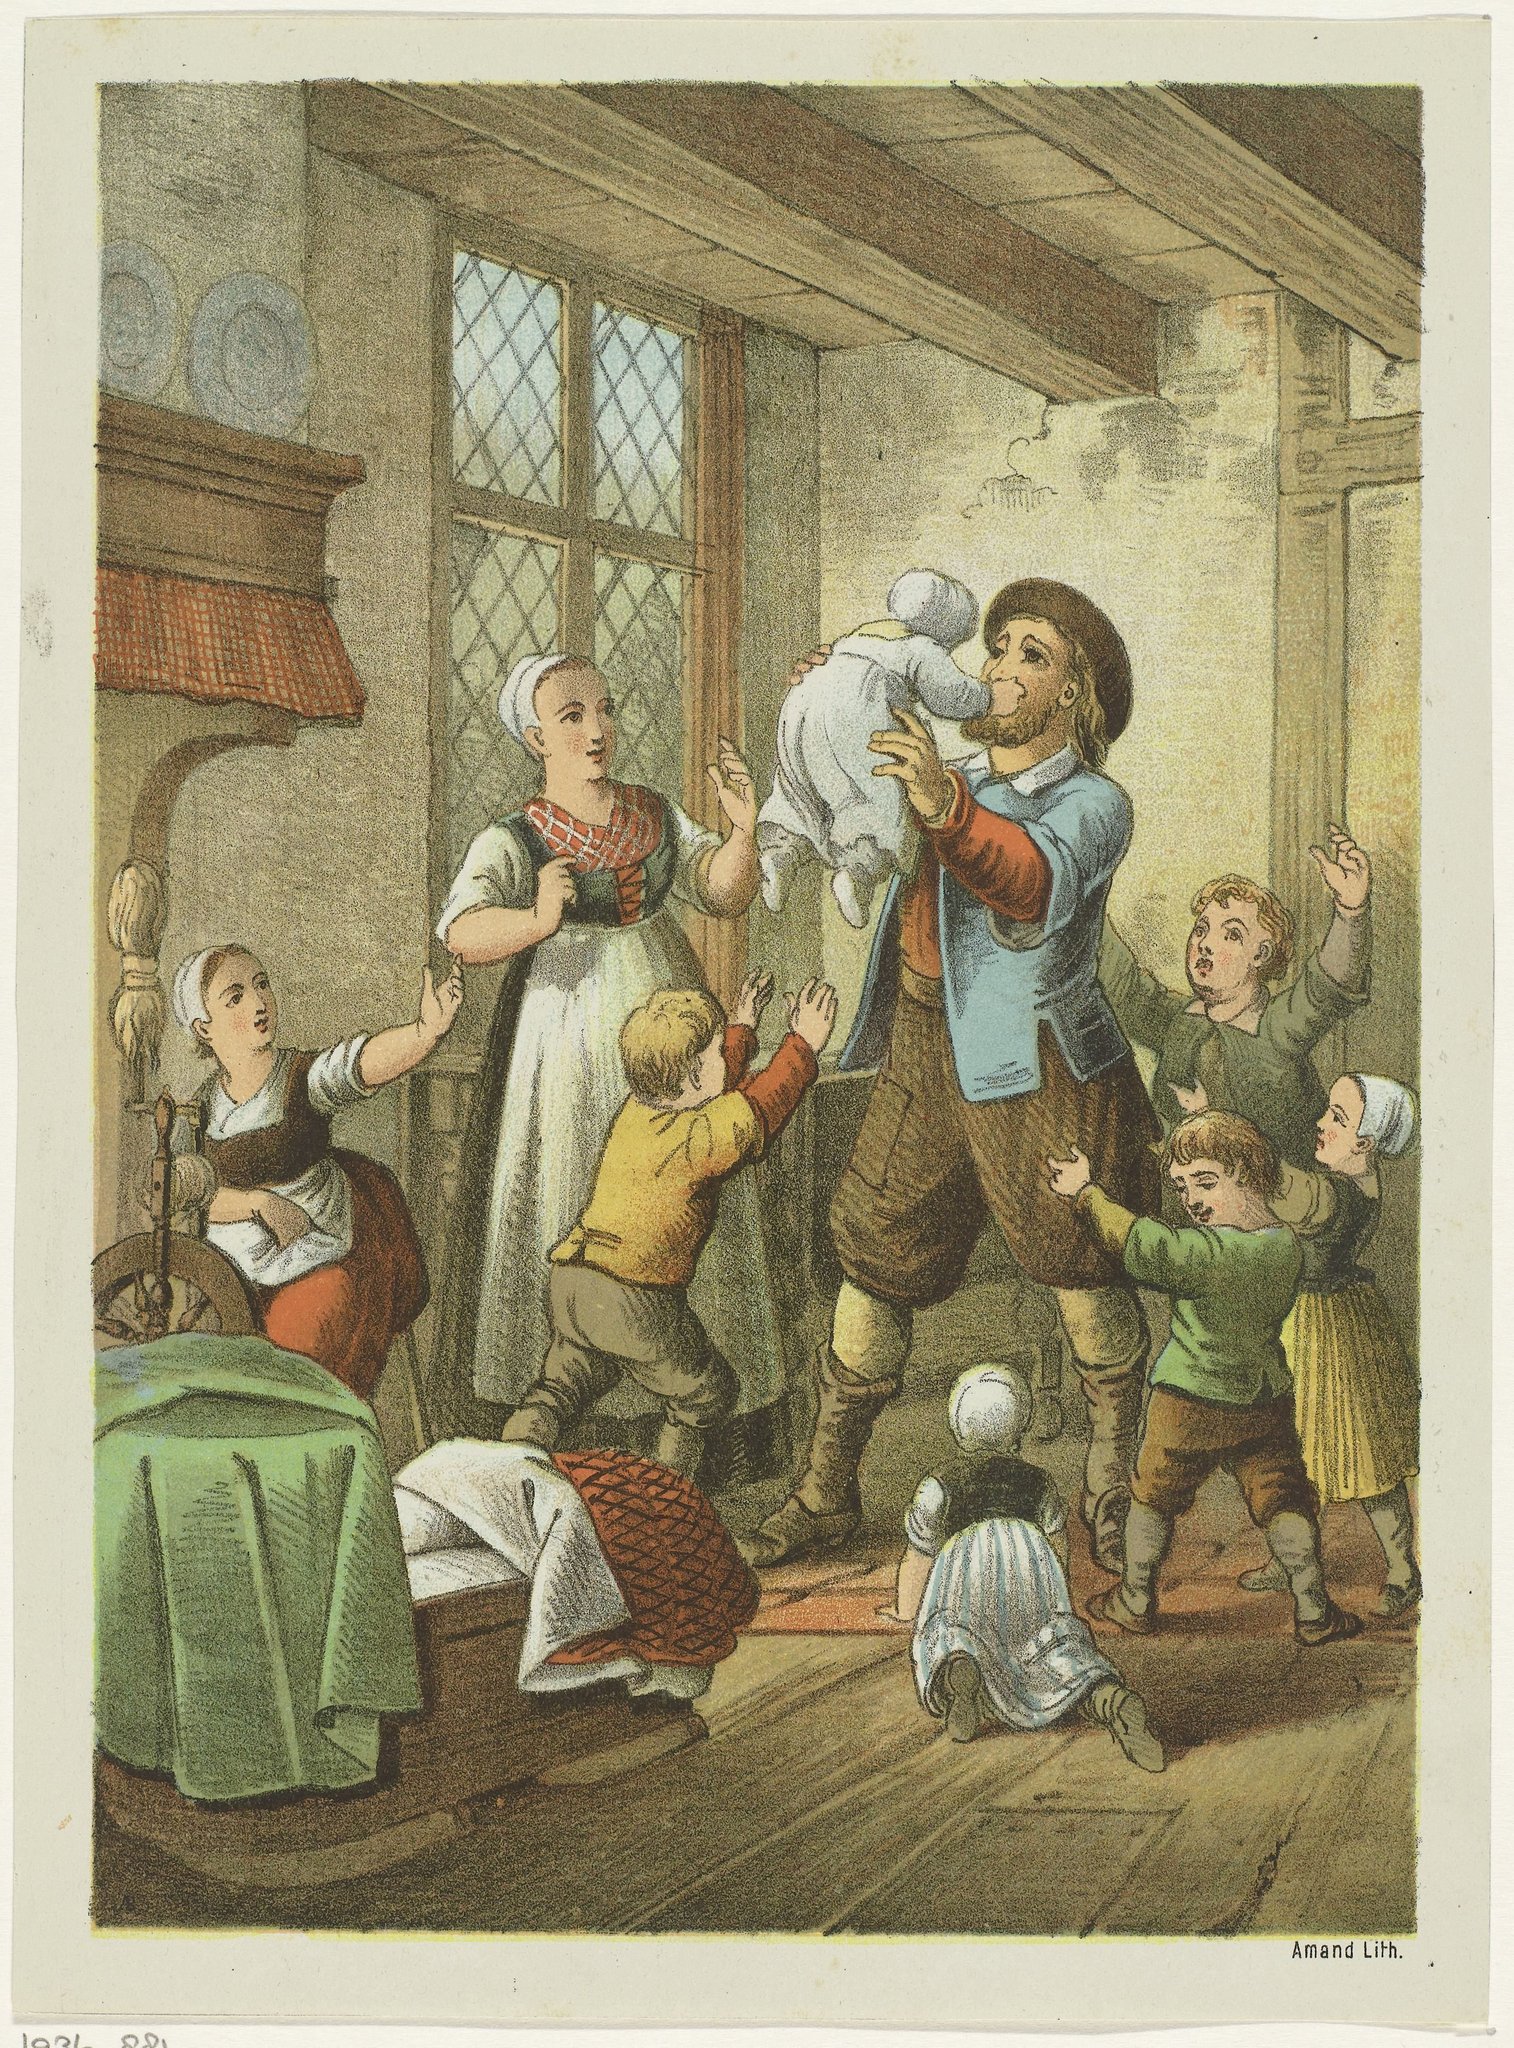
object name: print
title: Weerzien tussen vader en gezin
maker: albertus barend hendrik braakensiek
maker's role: print maker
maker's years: 1841-1884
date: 1867-1884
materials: paper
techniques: lithograph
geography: amsterdam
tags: spinning-wheel, family life at home, recognizing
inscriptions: collector's mark: Lugt 2228, collector's mark: Lugt 2760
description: Een vader staat te midden van zijn vrouw en kinderen. Hij tilt een van de jongste kinderen op tot bij zijn gezicht, de andere kinderen staan juichend om hem heen. In de kamer staan een spinnewiel, een wieg en een open haard met borden op de schoorsteenmantel.